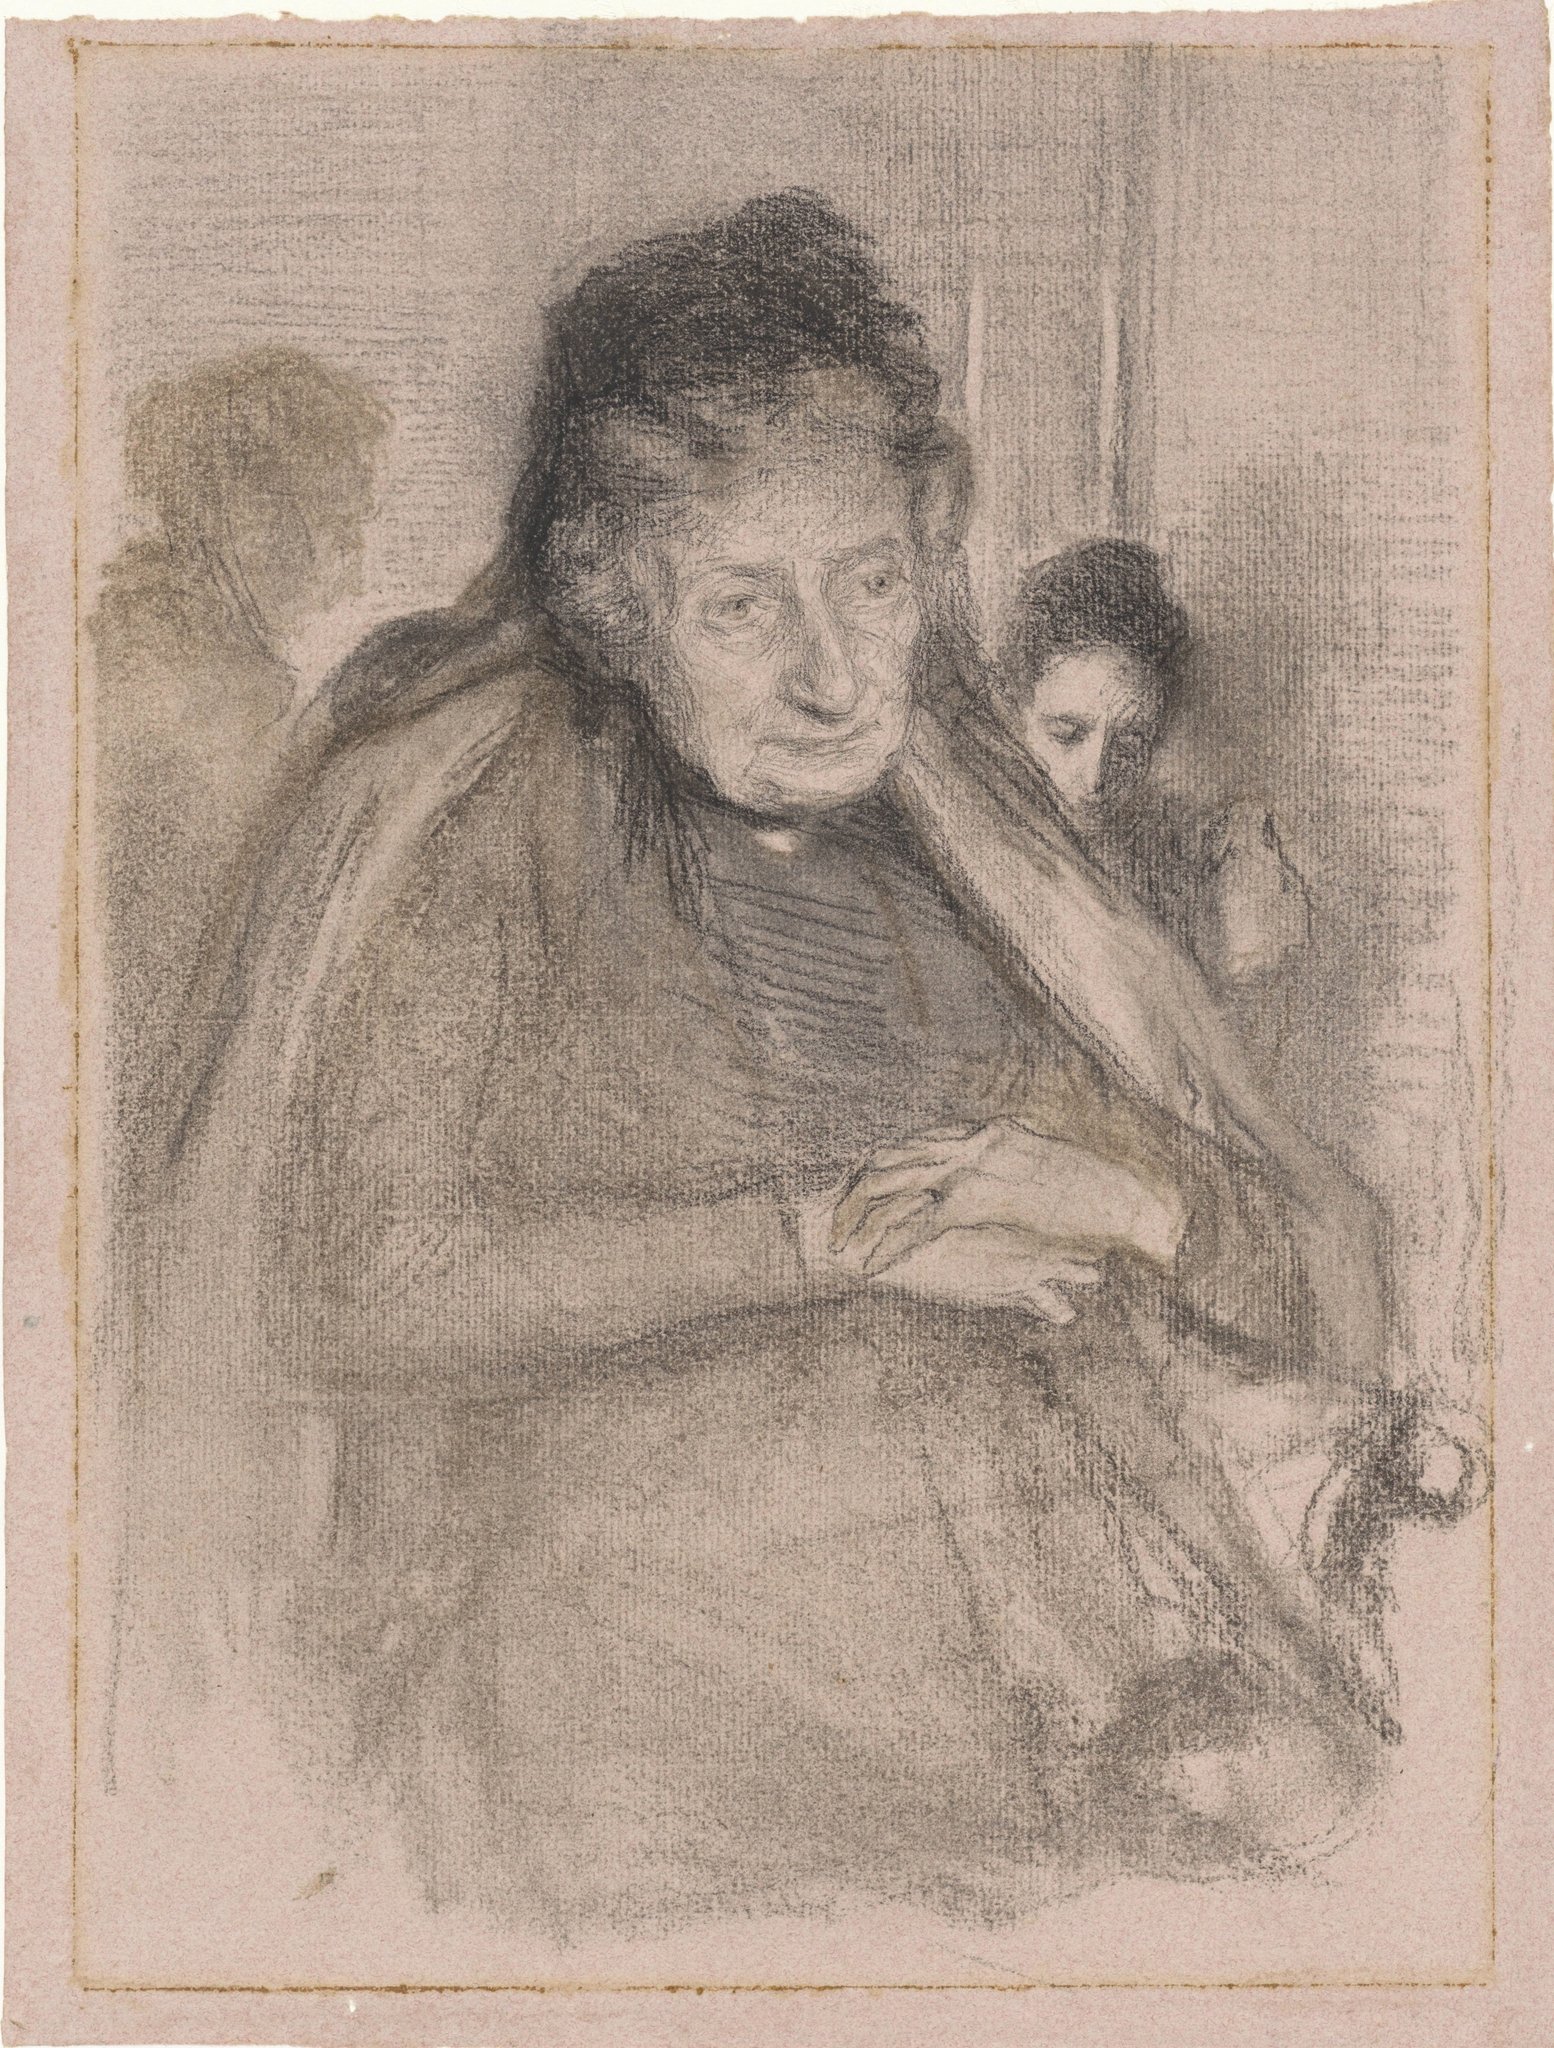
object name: drawing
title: Portret van mevrouw Pruys van der Hoeven-Trompet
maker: a.a.l. de grammont-hubrecht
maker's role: draughtsman, painter, print maker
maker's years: 1855-1913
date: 1865-1913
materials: chalk, paper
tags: historical persons